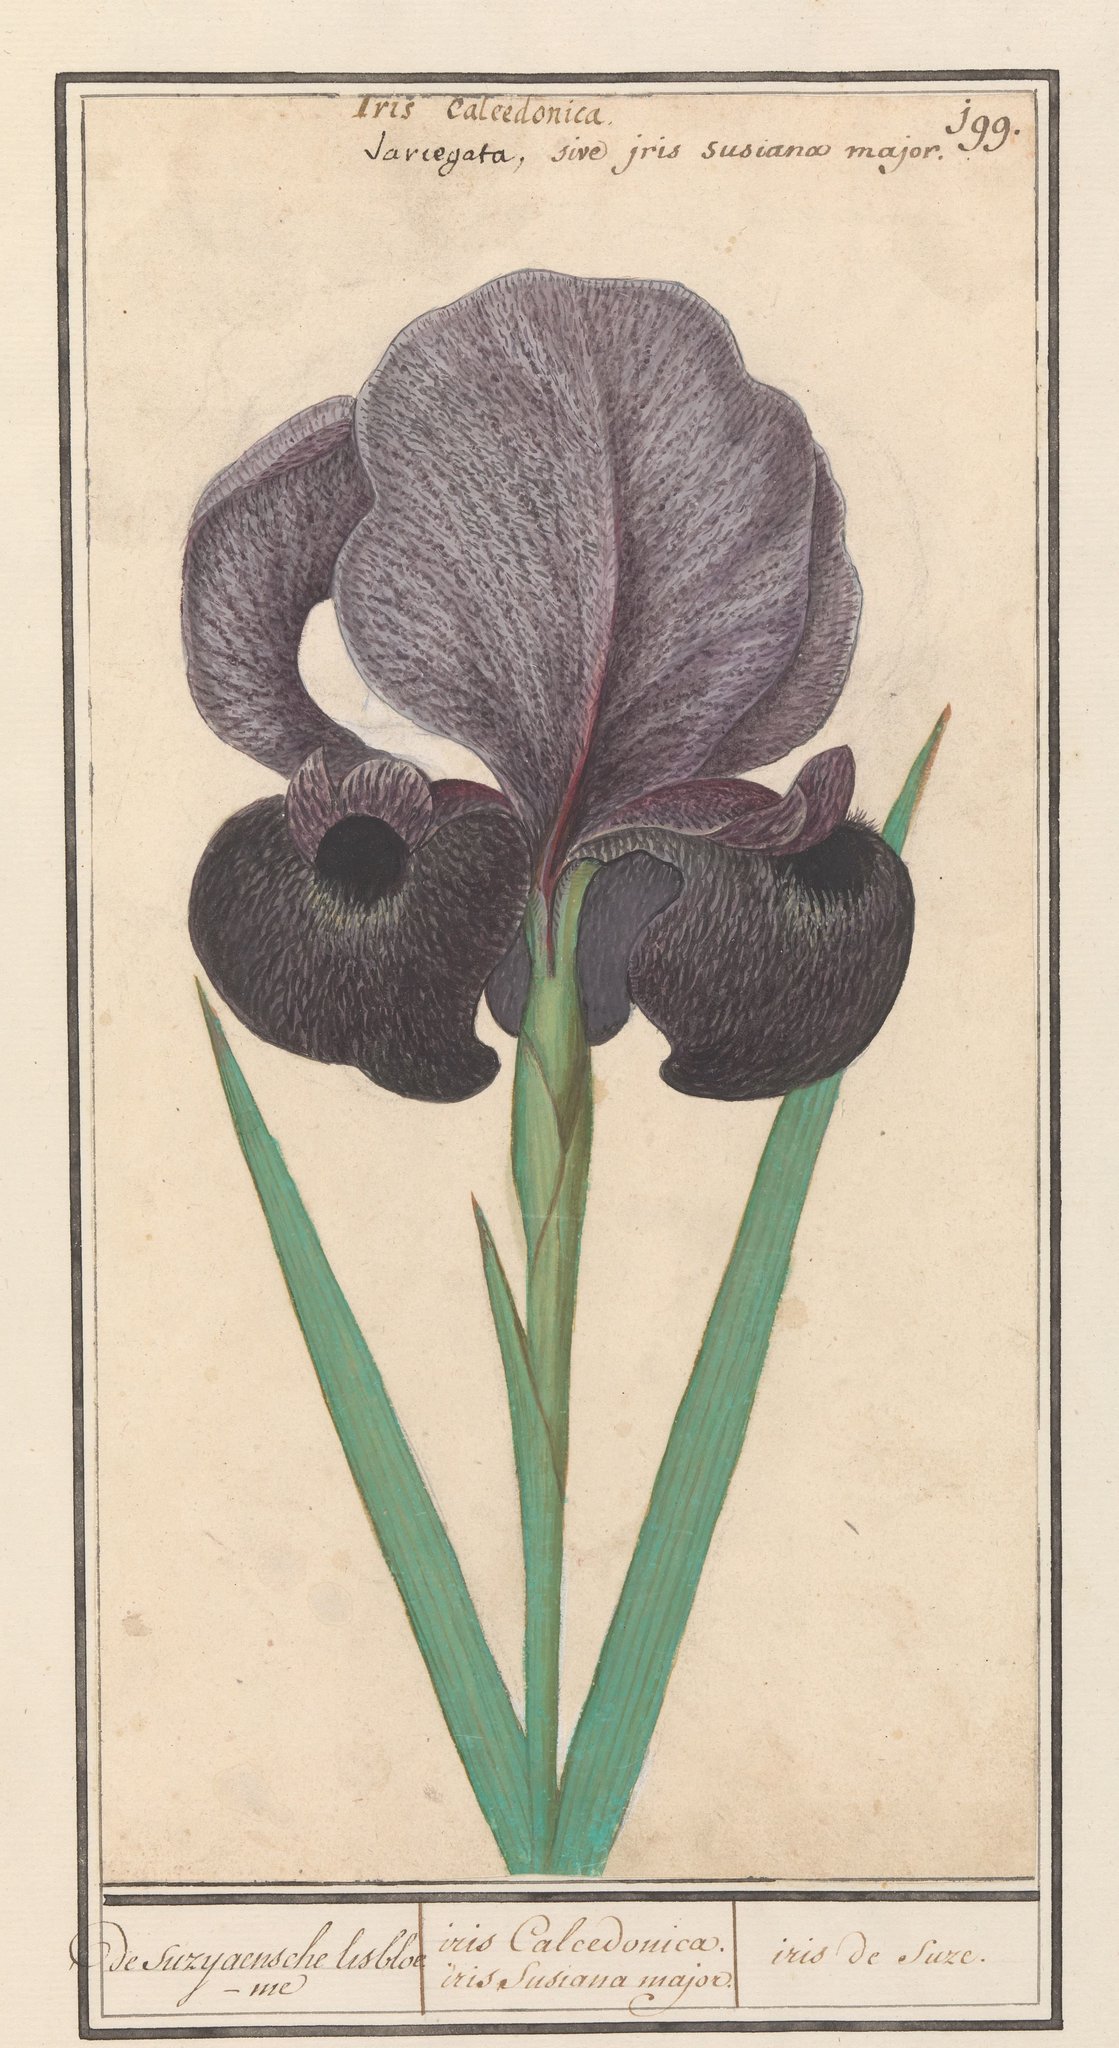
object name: drawing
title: Rouw iris (Iris susiana)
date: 1596-1610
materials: chalk, paint, ink, paper, watercolor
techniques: brush, pen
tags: flowers: iris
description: Paarse rouw iris, Iris susiana. Genummerd rechtsboven: 199. Bovenaan de Latijnse naam. Onderdeel van het tweede album met tekeningen van bloemen en planten. Negende van twaalf albums met tekeningen van dieren, vogels en planten bekend rond 1600, gemaakt in opdracht van keizer Rudolf II. Met toelichting in Nederlands, Latijn en Frans.